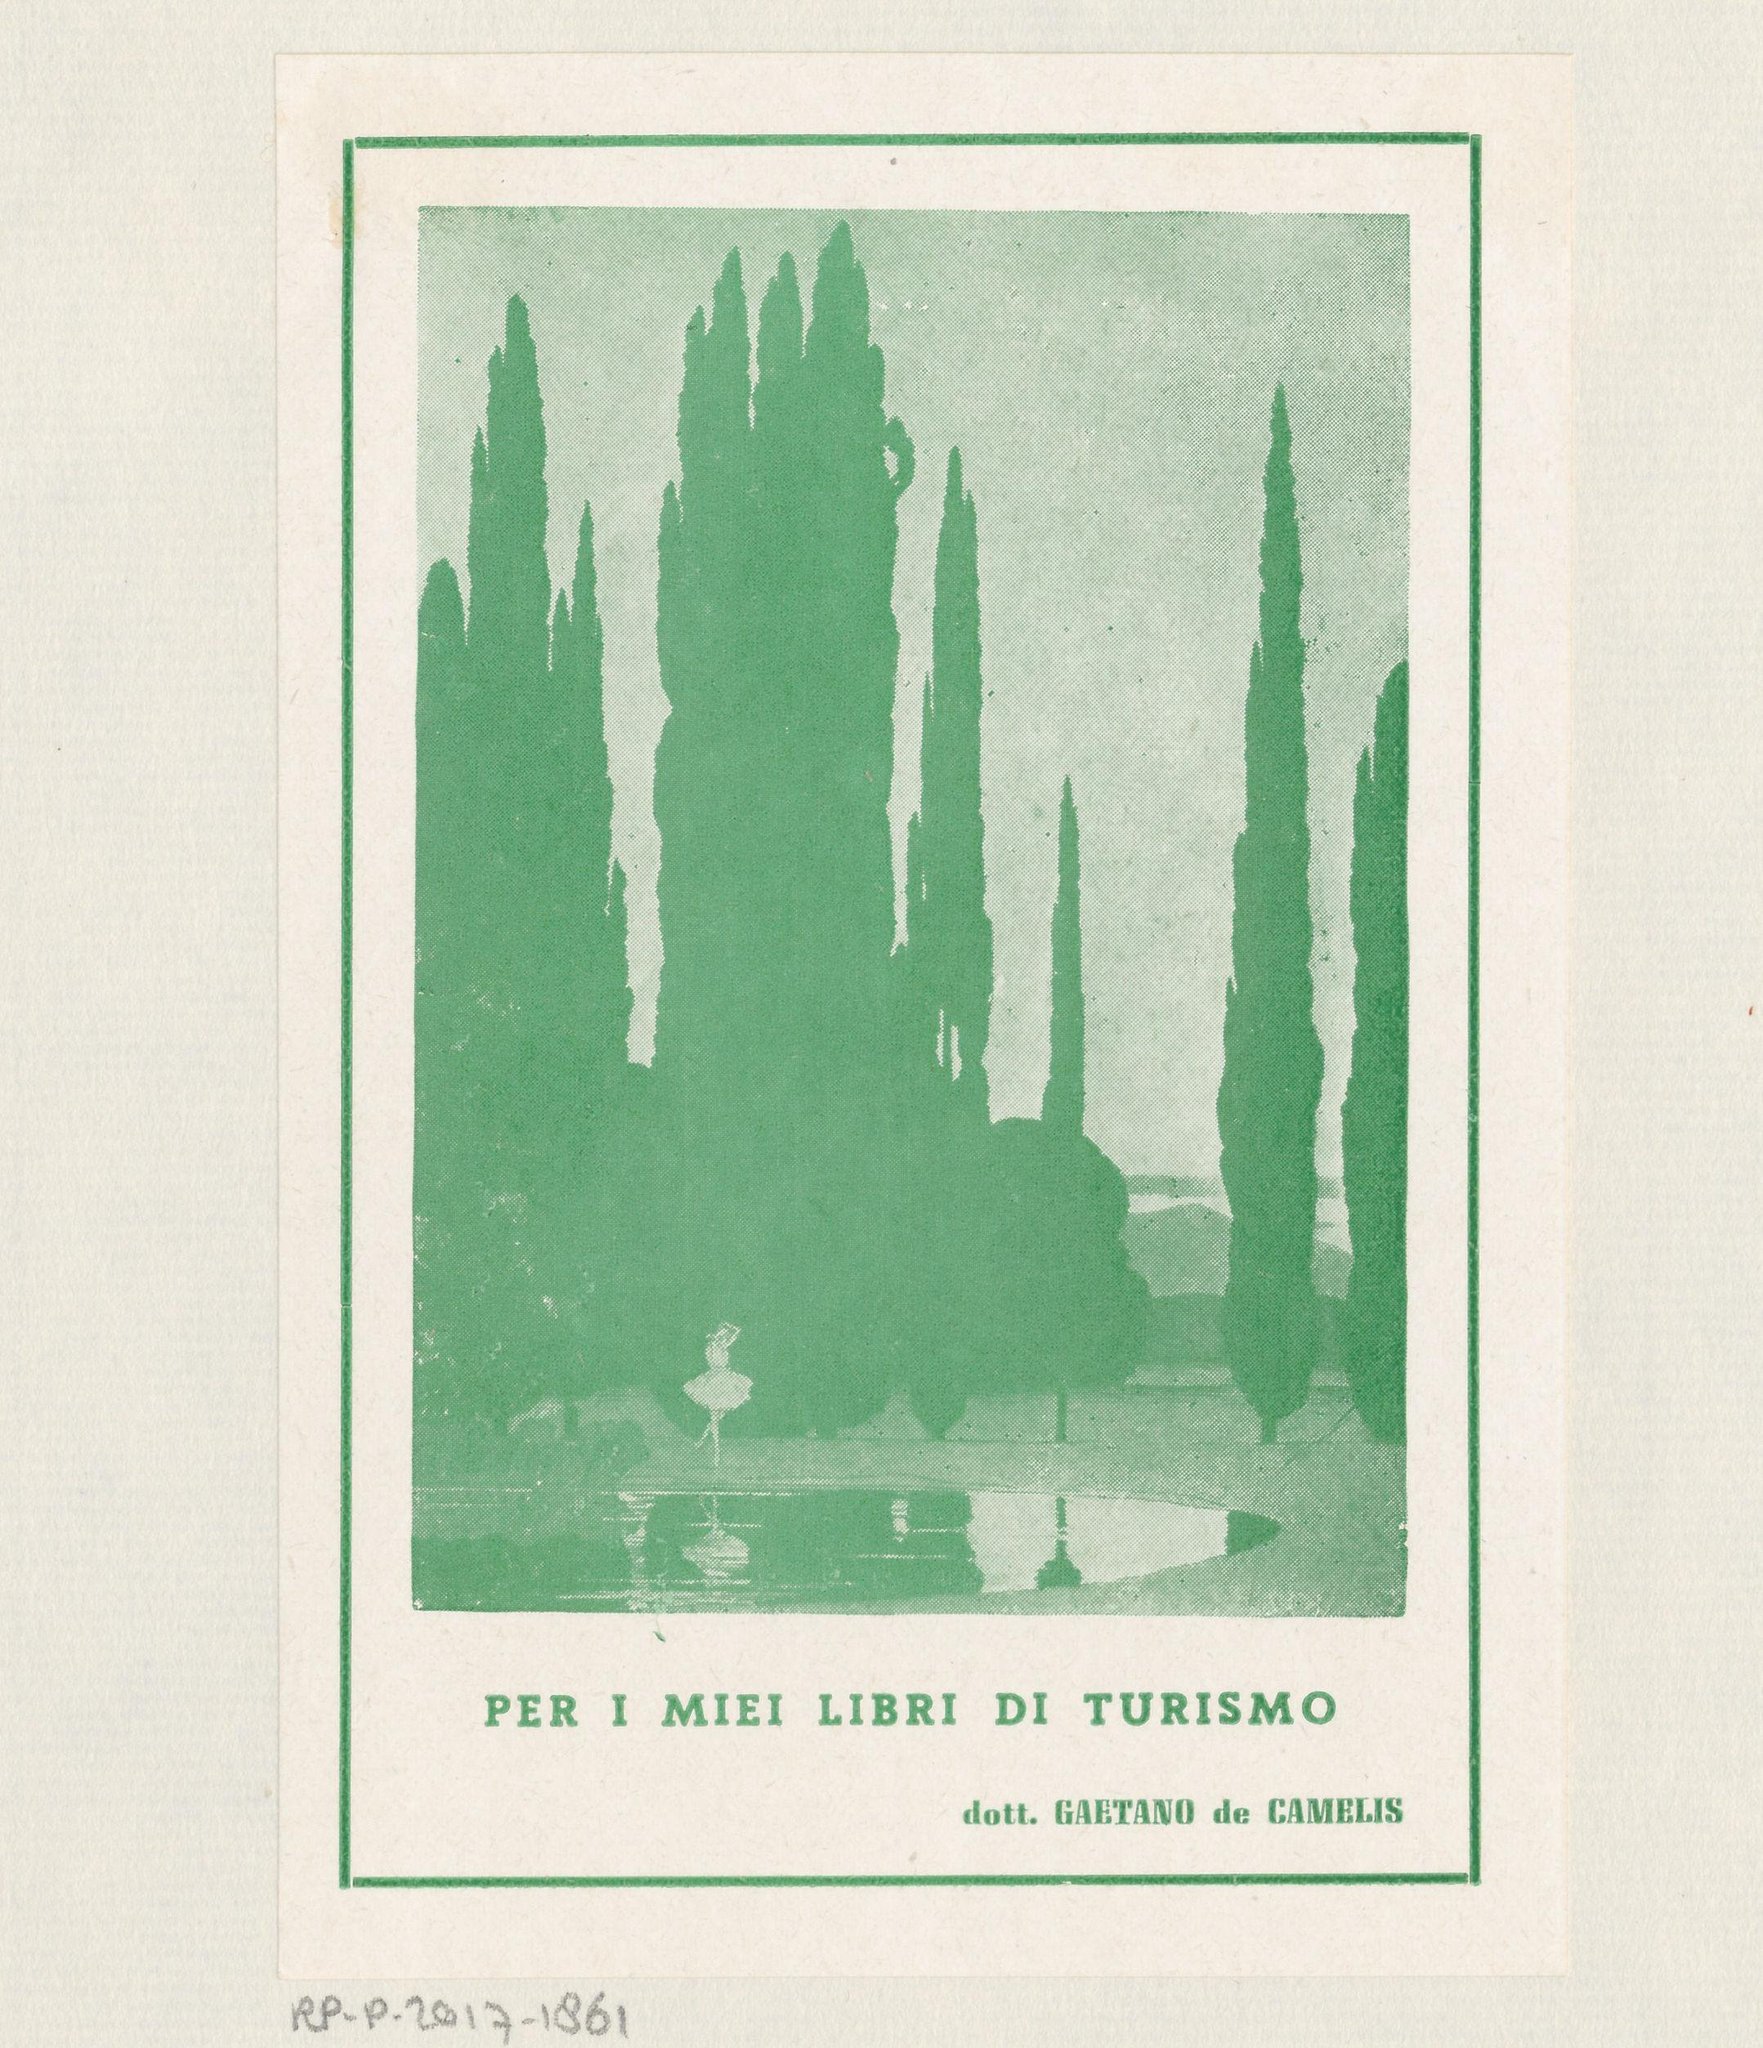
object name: photomechanical print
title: Ex libris van Gaetano de Camelis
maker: Anonymous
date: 1900-1999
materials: paper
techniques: autotype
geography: italy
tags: trees: cypress, lake, female dancer